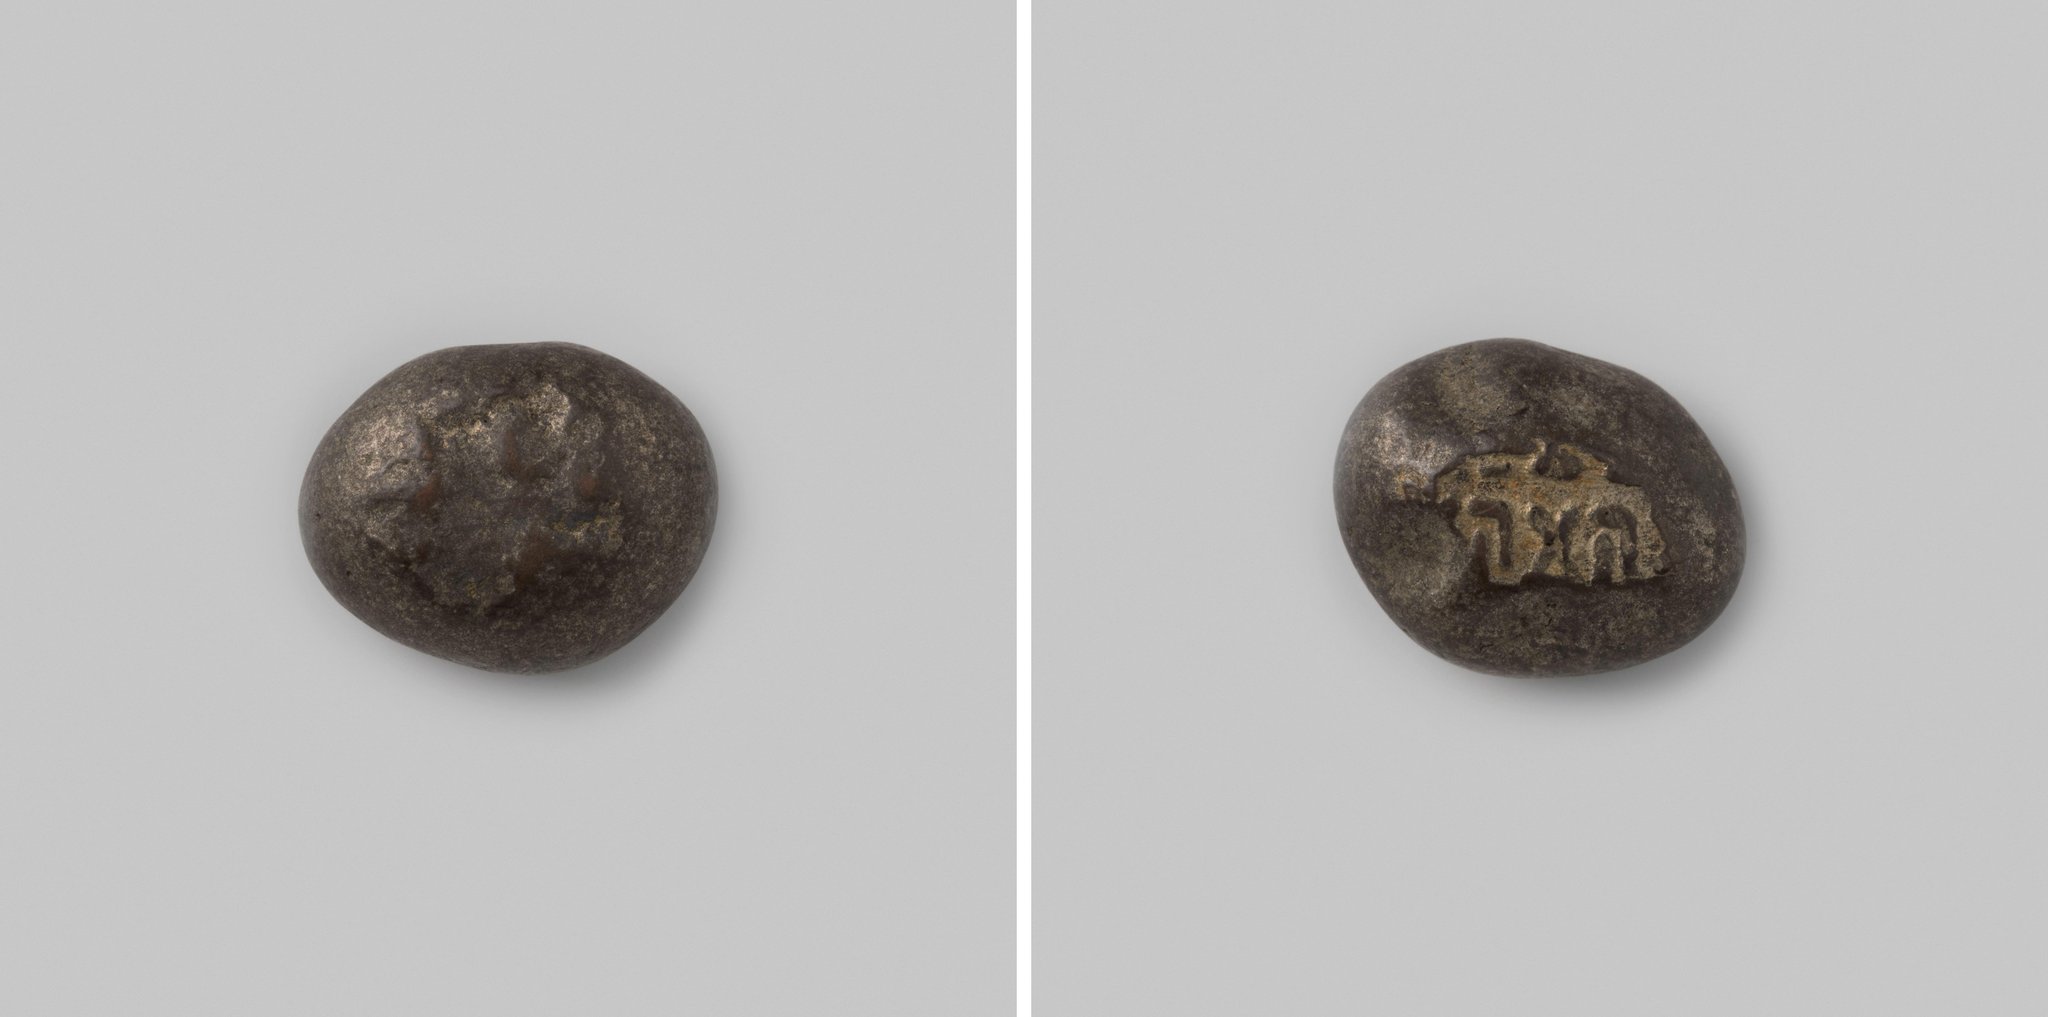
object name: coin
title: Mametita-gin [=zilveren boontje] van 1 bu van het keizerrijk Japan, uit de 17e, 18e en 19e eeuw tot 1865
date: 1600-1836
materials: silver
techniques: striking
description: Zilveren langwerpige munt. Voorzijde: deel van een formele inscriptie met tijdperk-aanduiding: Of: "God van de Veelvuldigheid-symbool met op zijn buik tijdperk-aanduiding. Keerzijde: glad.